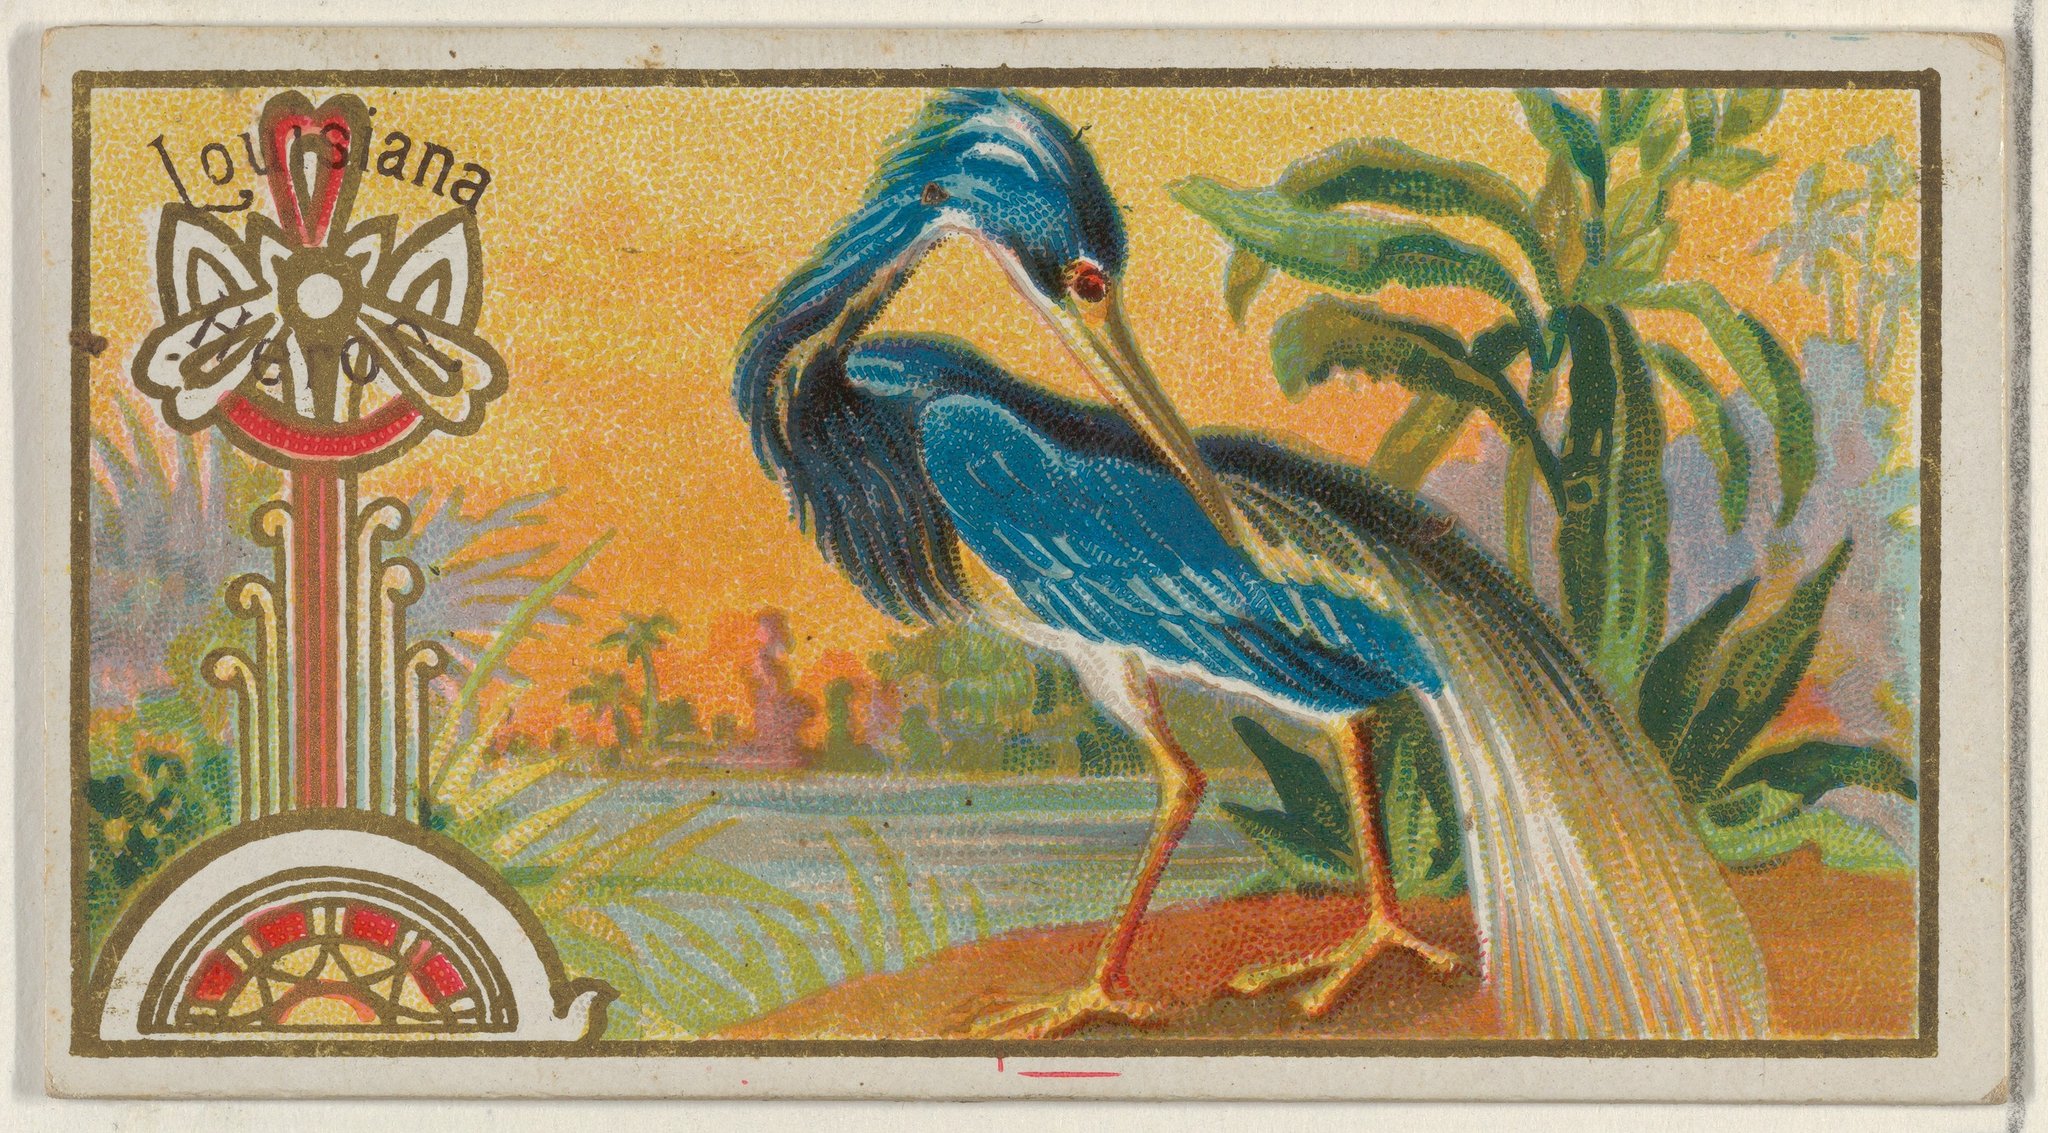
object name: print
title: Louisiana Heron, from the Game Birds series (N13) for Allen & Ginter Cigarettes Brands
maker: allen & ginter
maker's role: publisher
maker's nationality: american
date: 1889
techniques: color lithograph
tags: birds